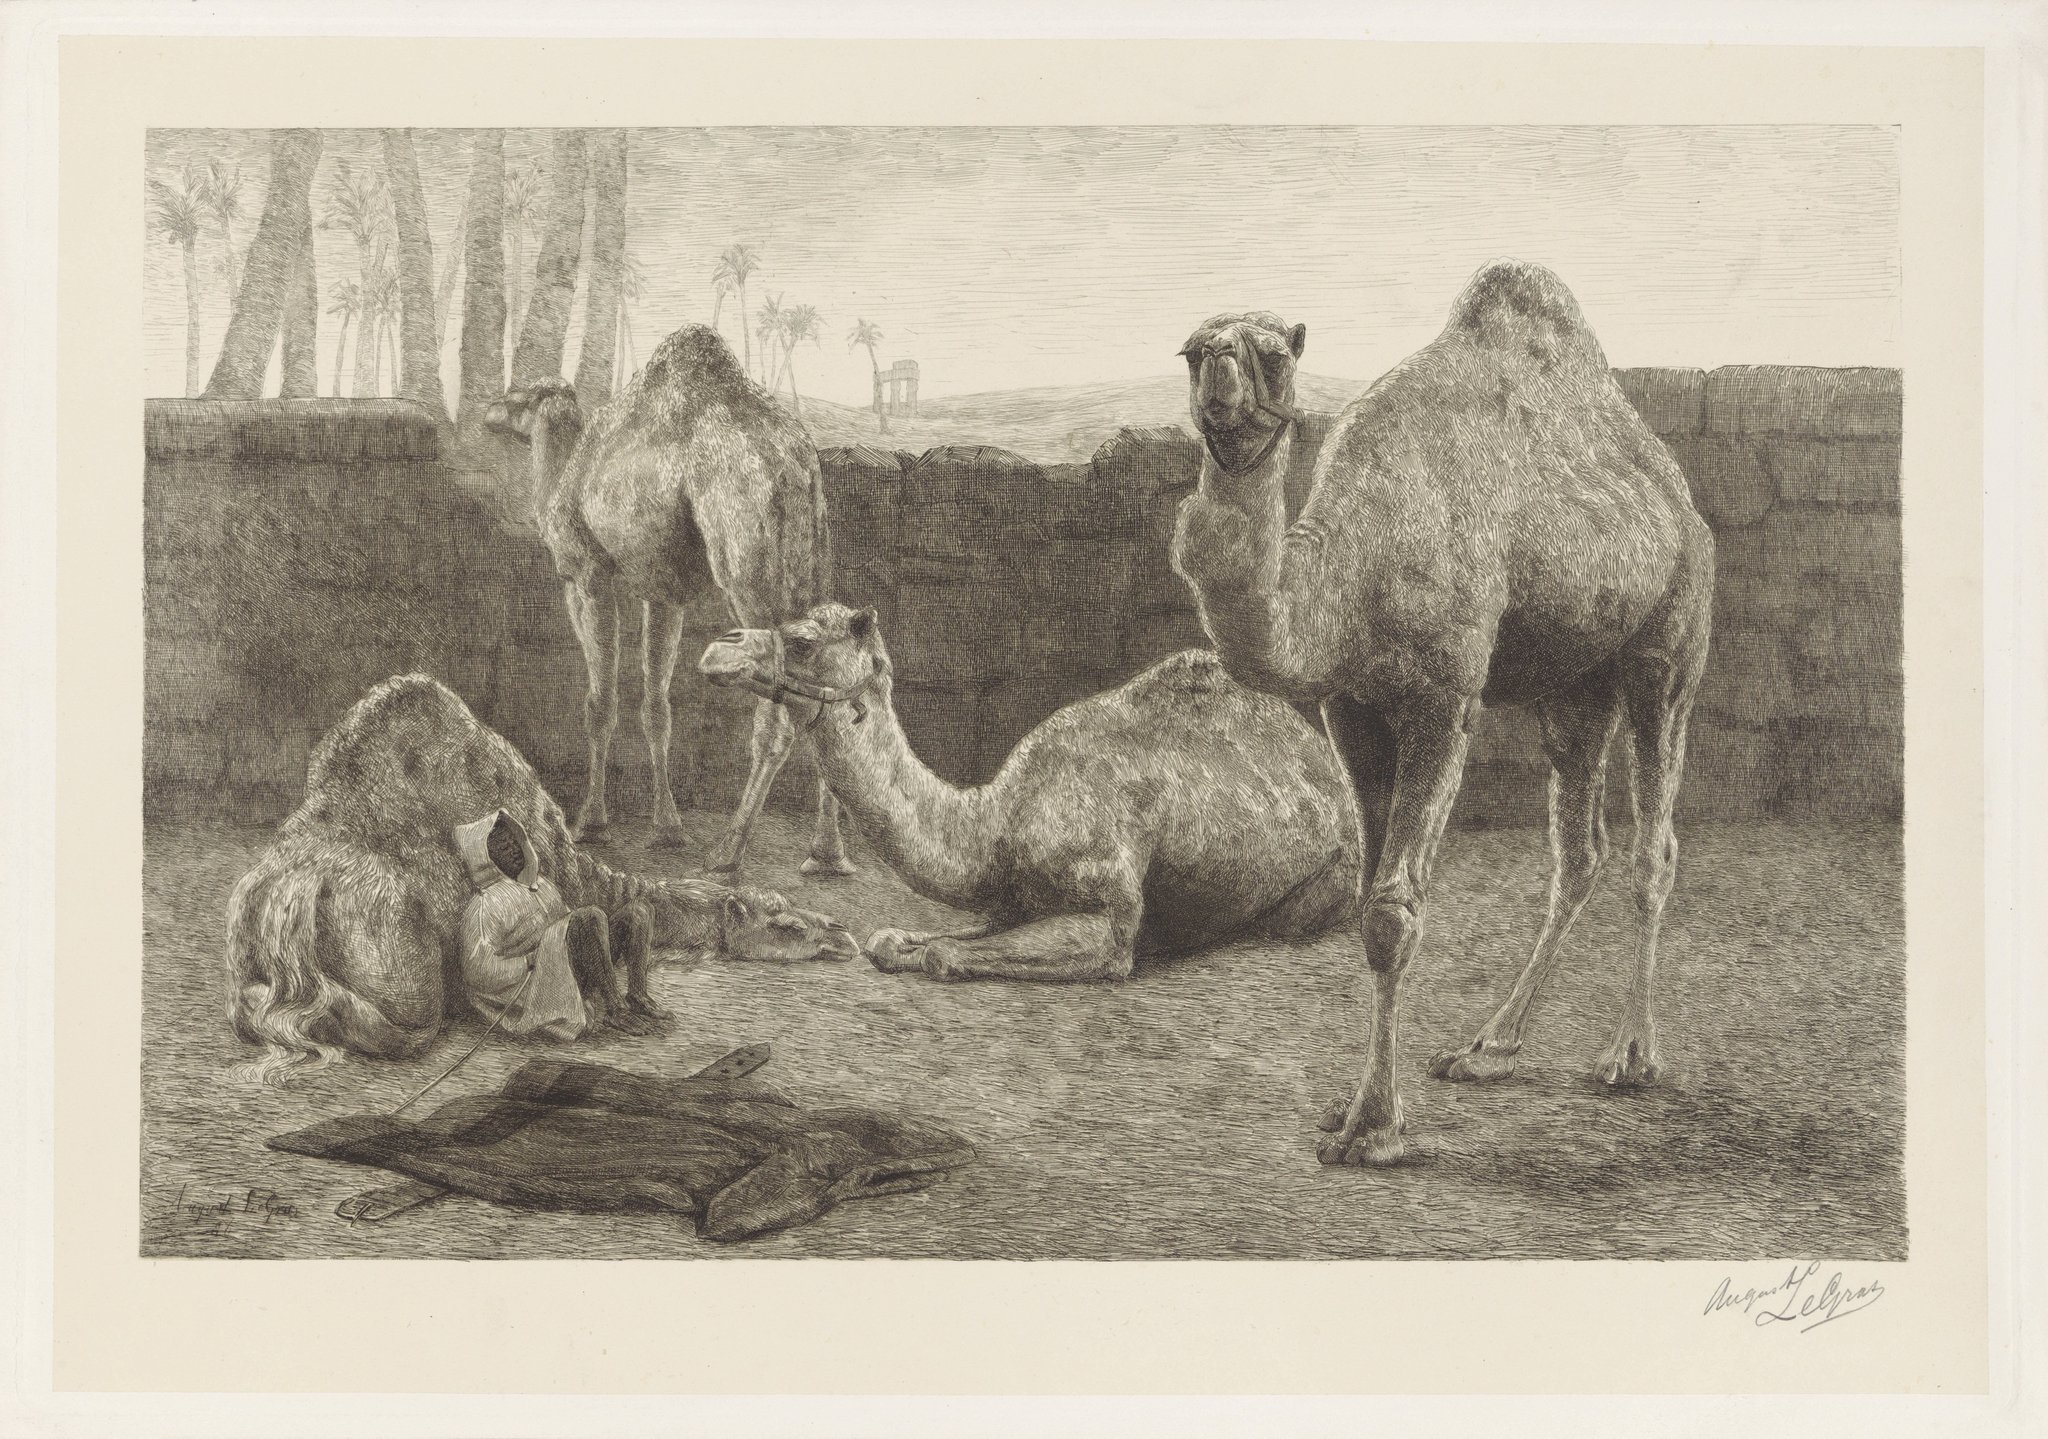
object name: print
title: Kamelen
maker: august le gras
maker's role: draughtsman, print maker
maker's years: 1864-1915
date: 1886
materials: paper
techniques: etching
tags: hoofed animals: camel, desert, trees: palm-tree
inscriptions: inscription: ‘August Le Gras’, collector's mark: Lugt 2228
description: Vier kamelen binnen stenen muren in de buitenlucht. Een jonge kamelendrijver leunt met zijn rug tegen een op de grond gelegen kameel. In de verte een uitgestrekte vlakte met enkele palmbomen.